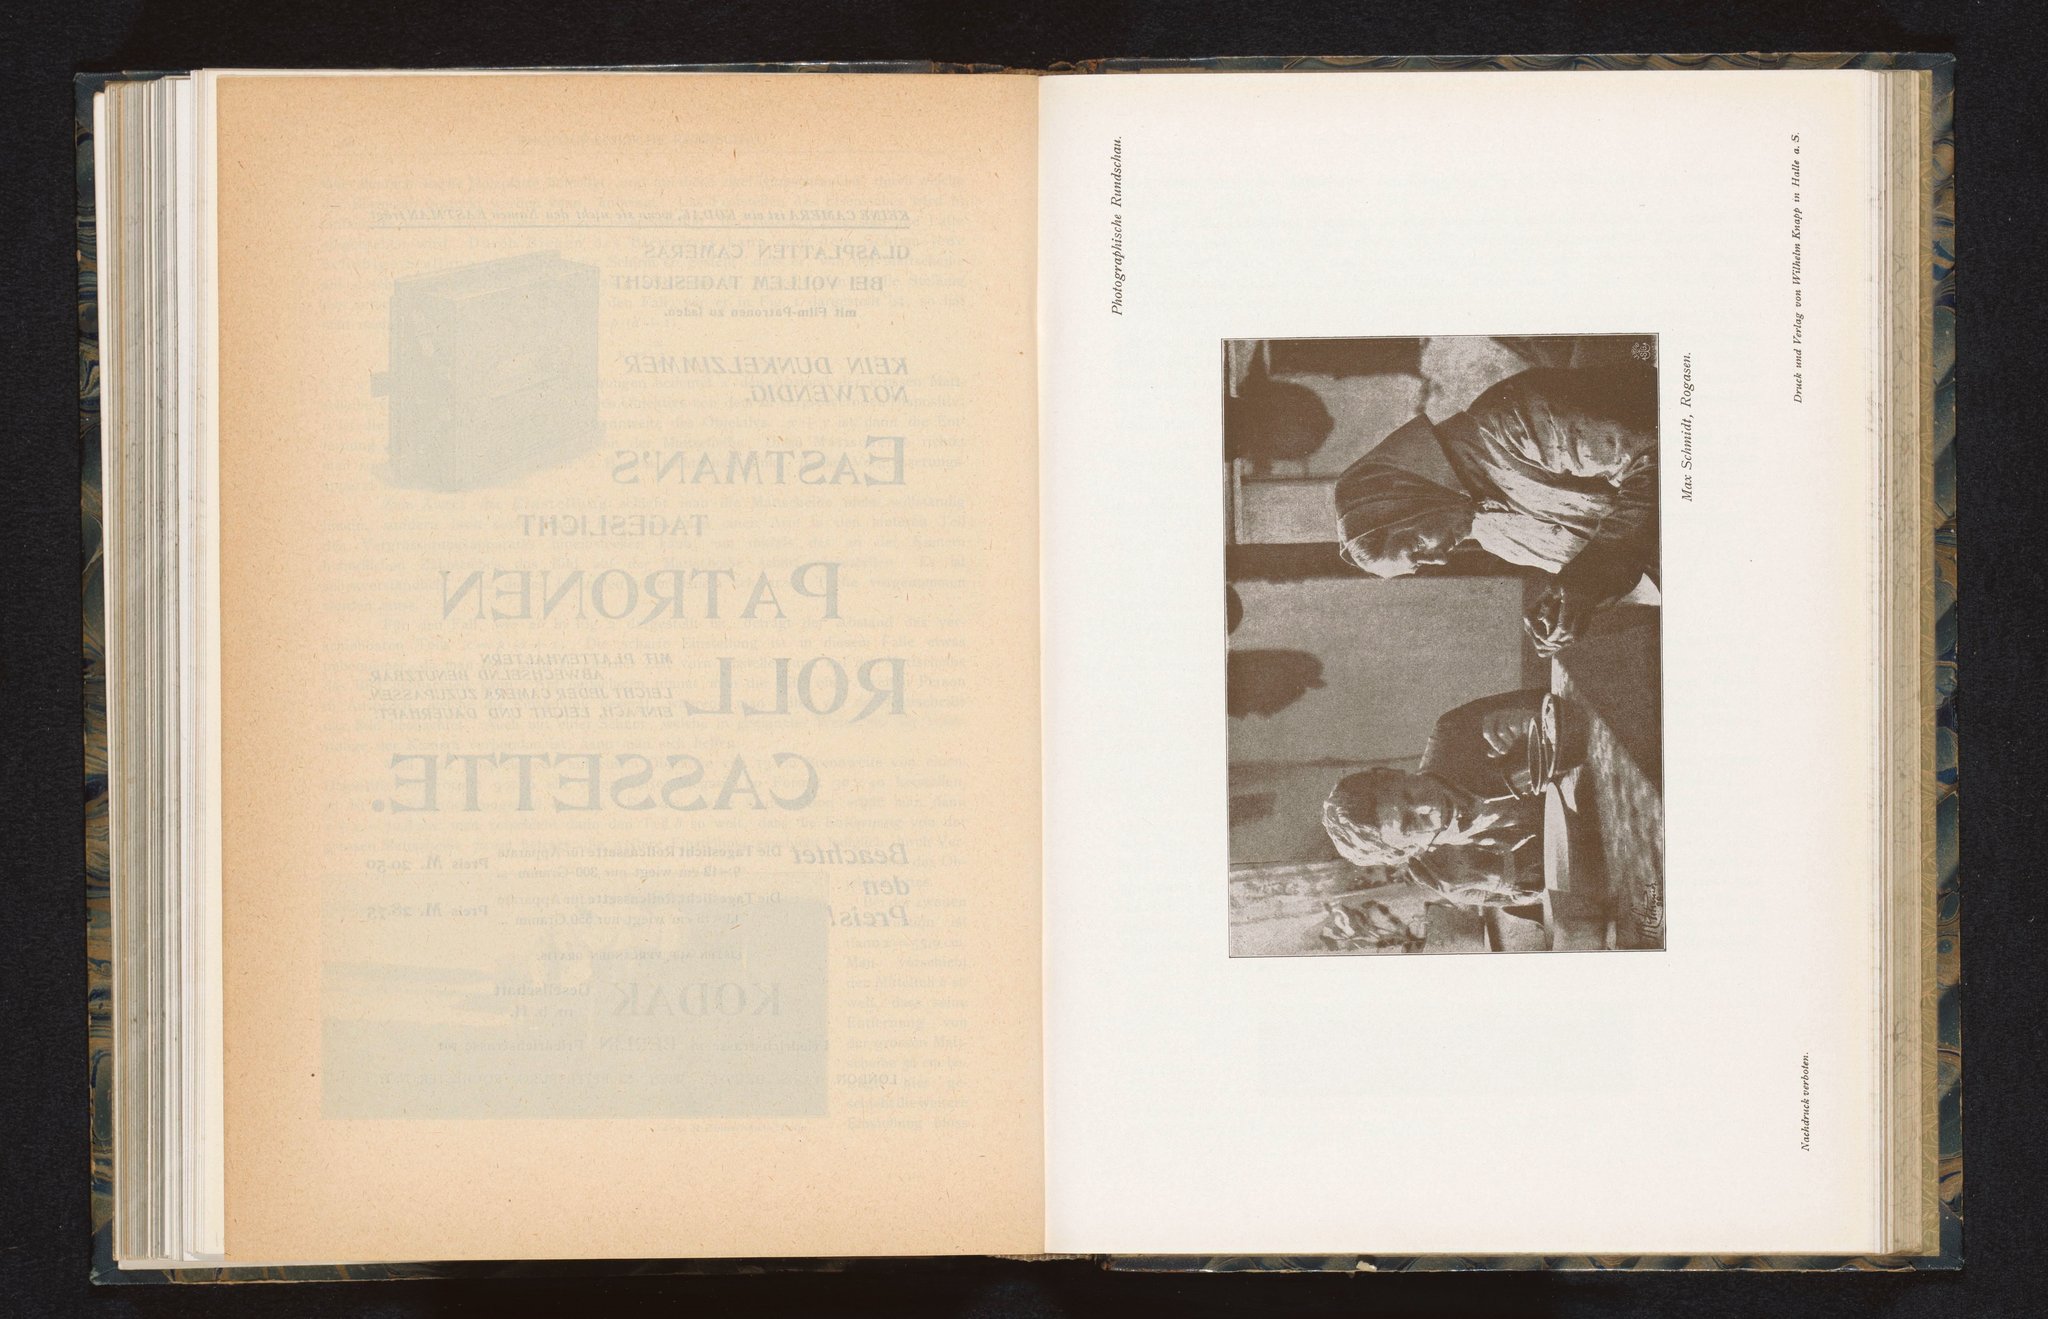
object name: page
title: Gezicht op een onbekende man en een vrouw aan tafel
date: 1895-1900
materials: paper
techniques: autotype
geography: halle an der saale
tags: adult woman, adult man, table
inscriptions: inscription: ‘Nachdruk verboten’, monogram: ‘Leipzig/ S.G.’